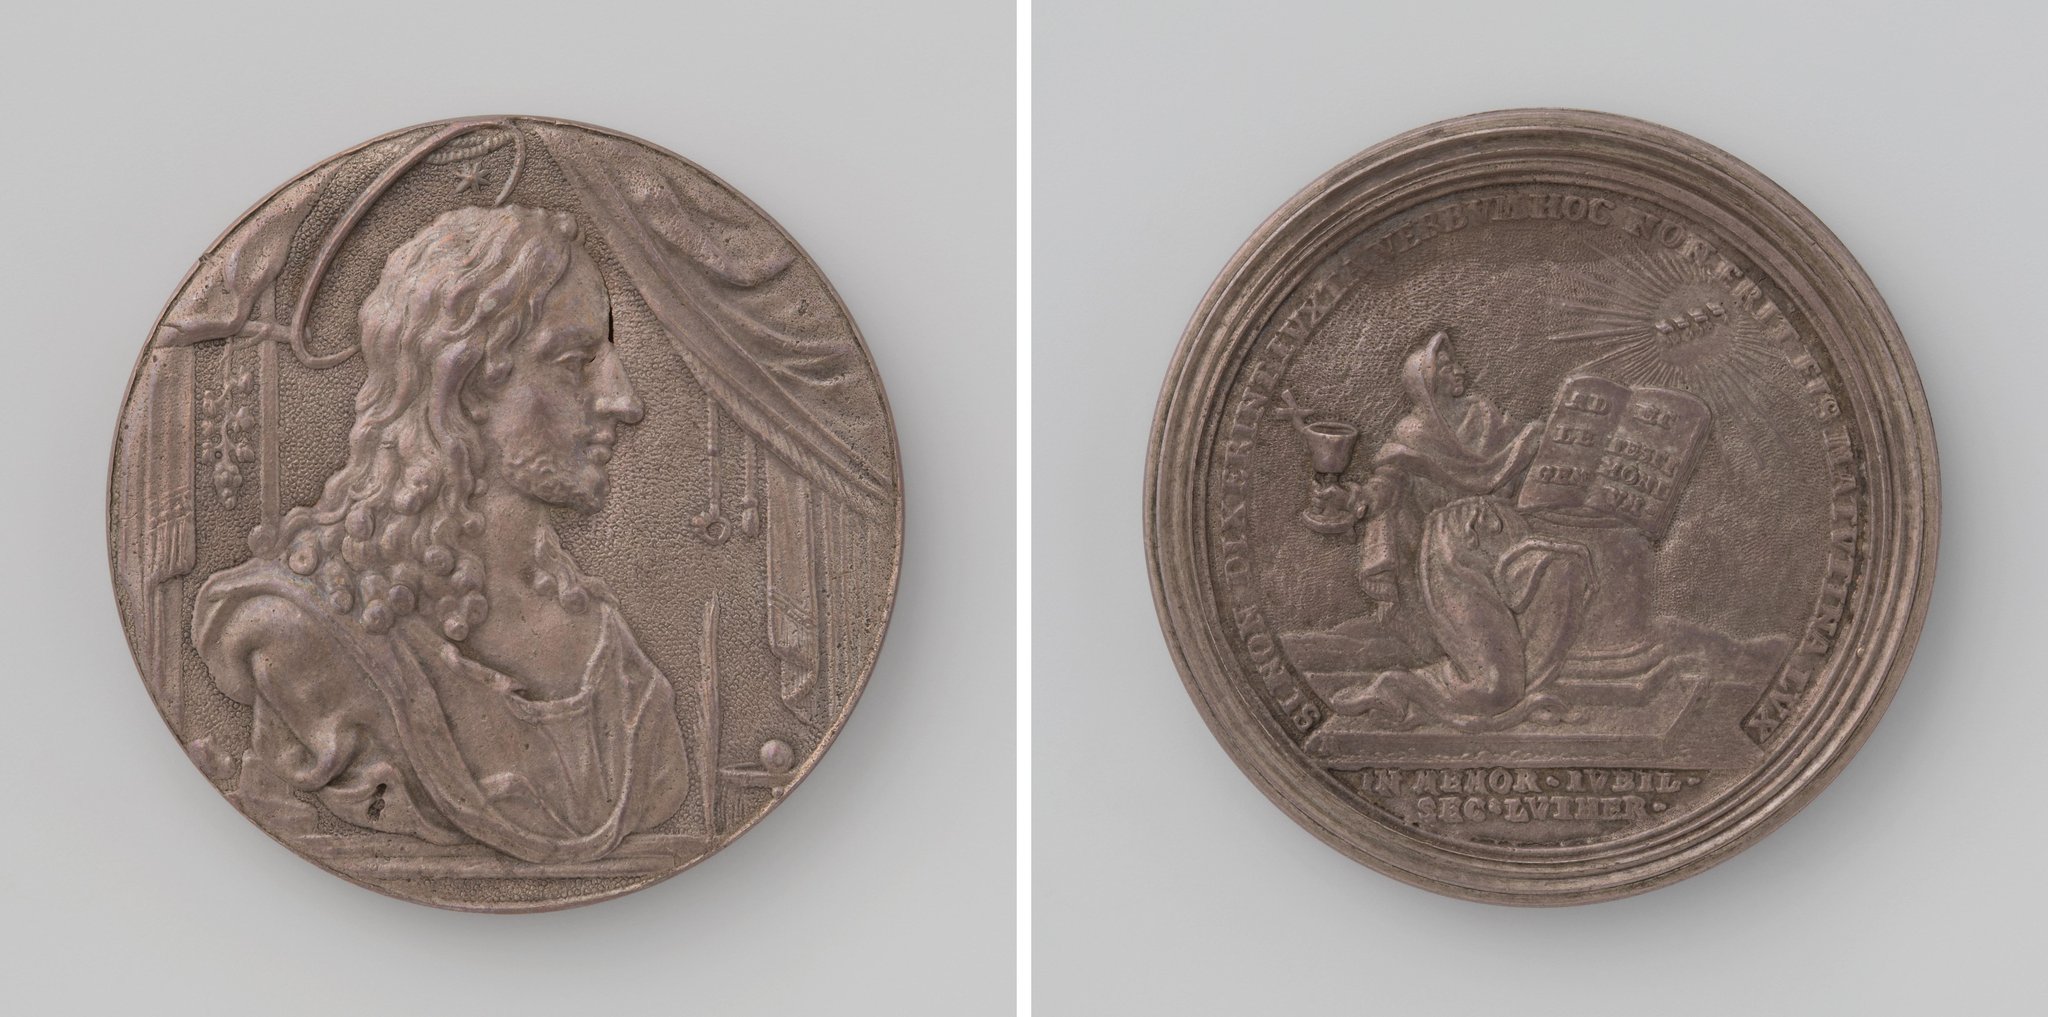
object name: history medal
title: Tweede eeuwfeest van de Reformatie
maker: Anonymous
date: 1717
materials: paper, silver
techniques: striking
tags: martin luther